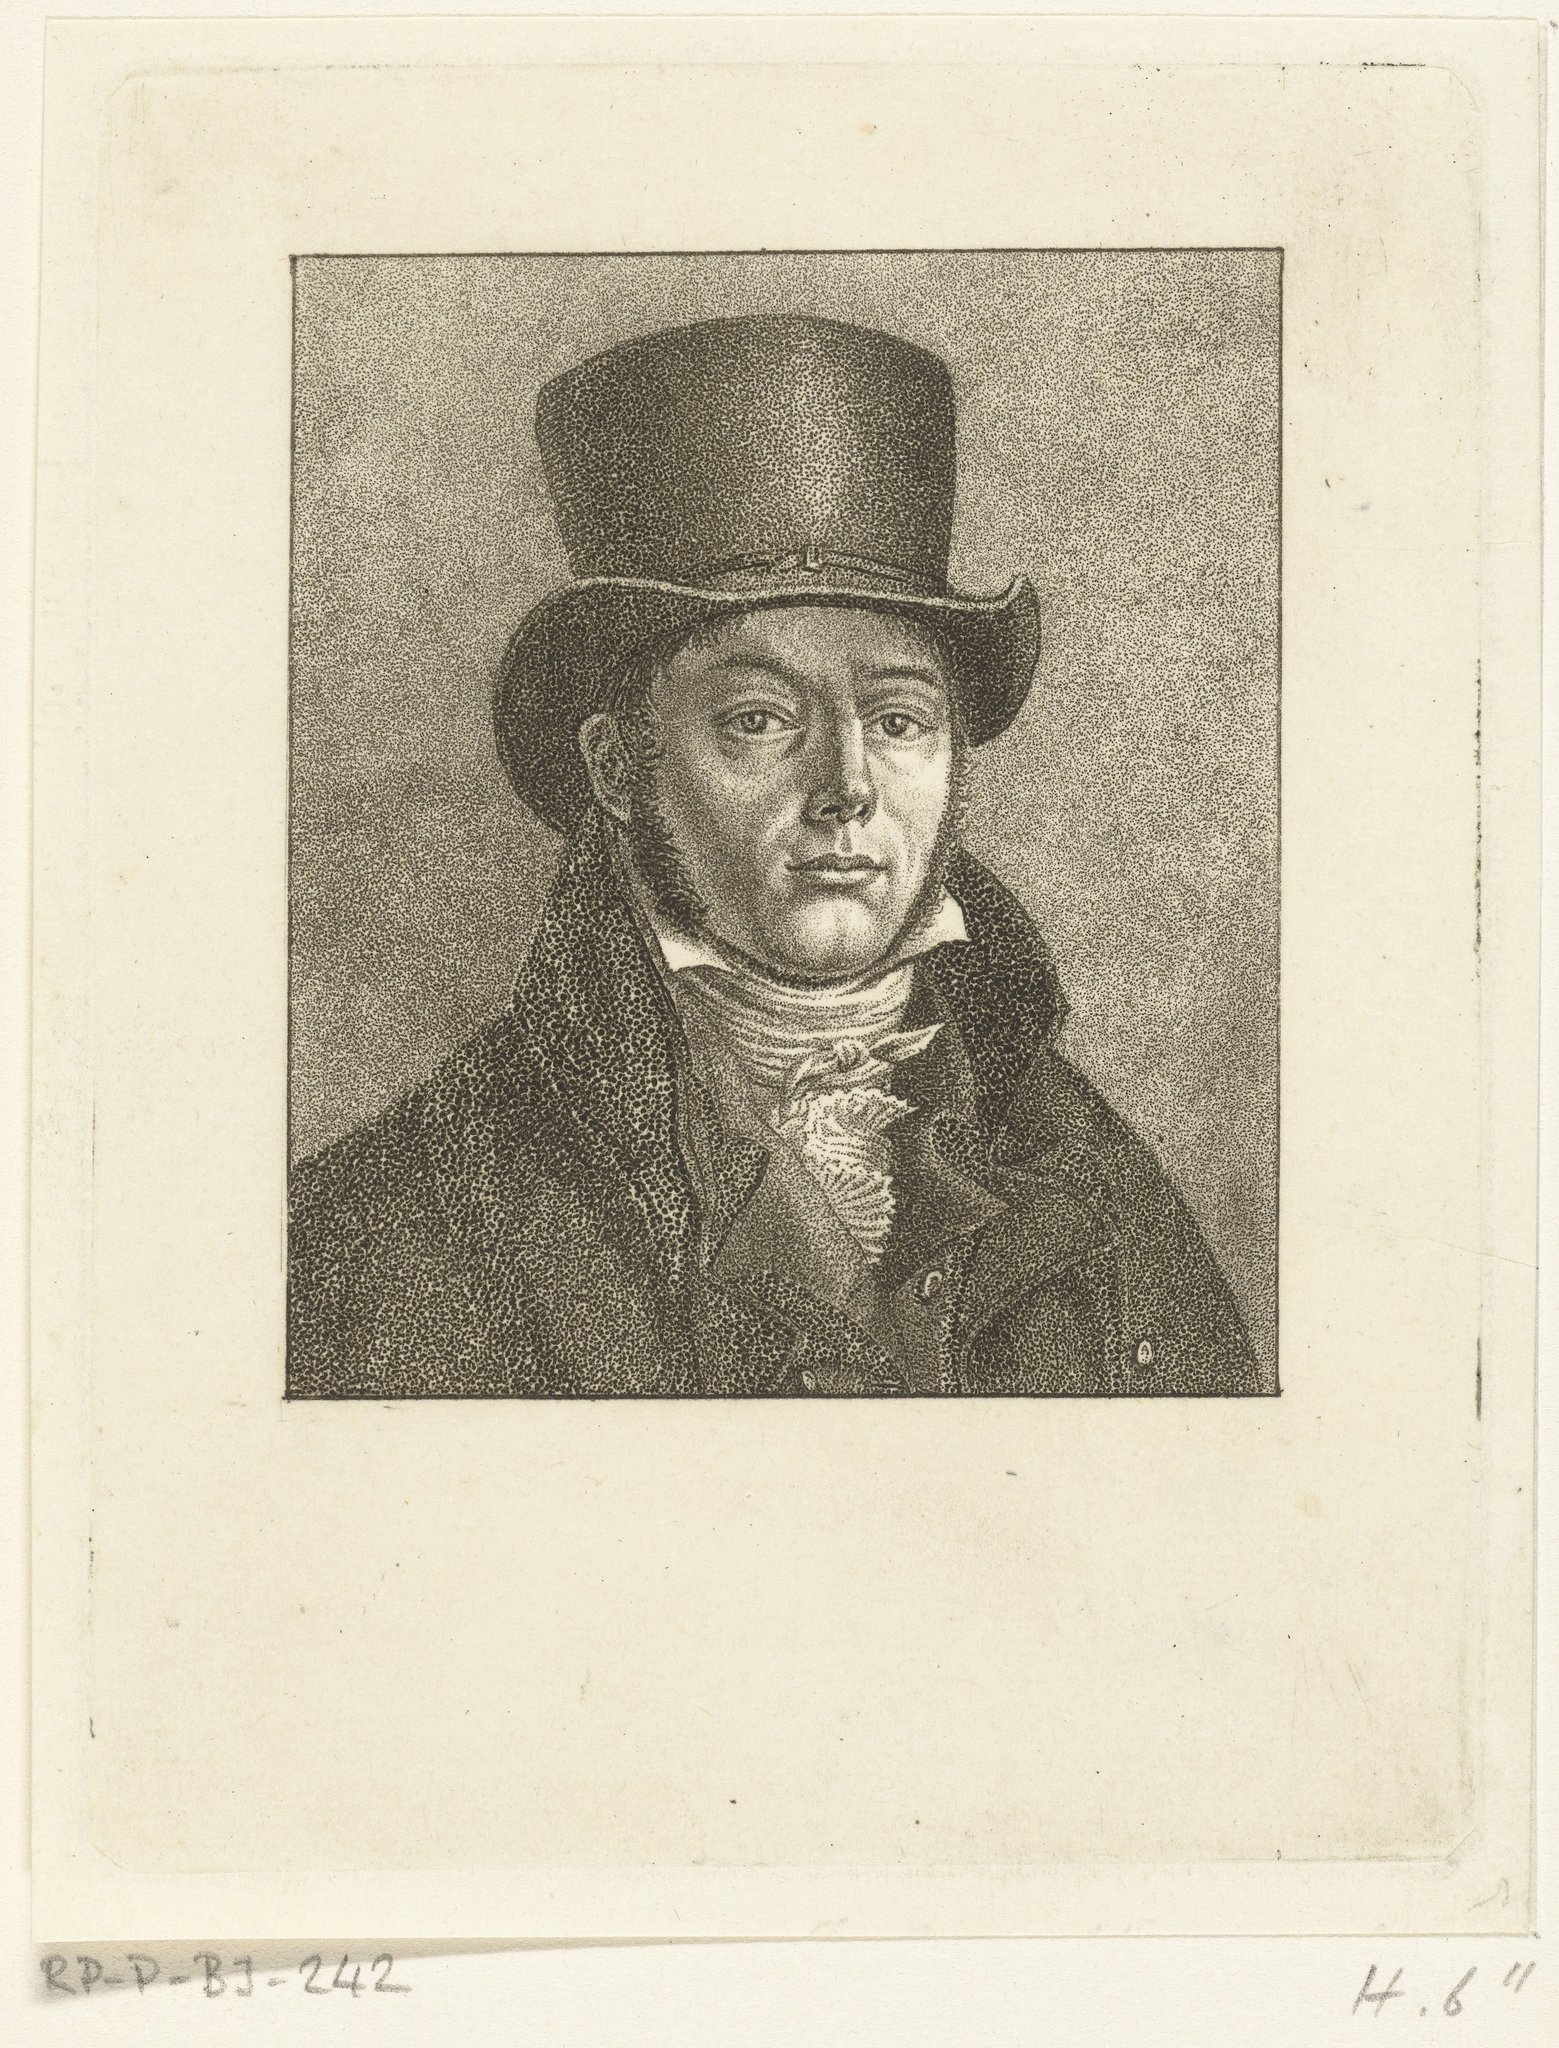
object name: print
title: Portret van Jacob Ernst Marcus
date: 1798-1826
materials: paper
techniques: aquatint, etching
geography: netherlands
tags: amsterdam, print maker, draughtsman, jacob ernst marcus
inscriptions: collector's mark: Lugt 2228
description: Portretbuste van Jacob Ernst Marcus met hoed en mantel.